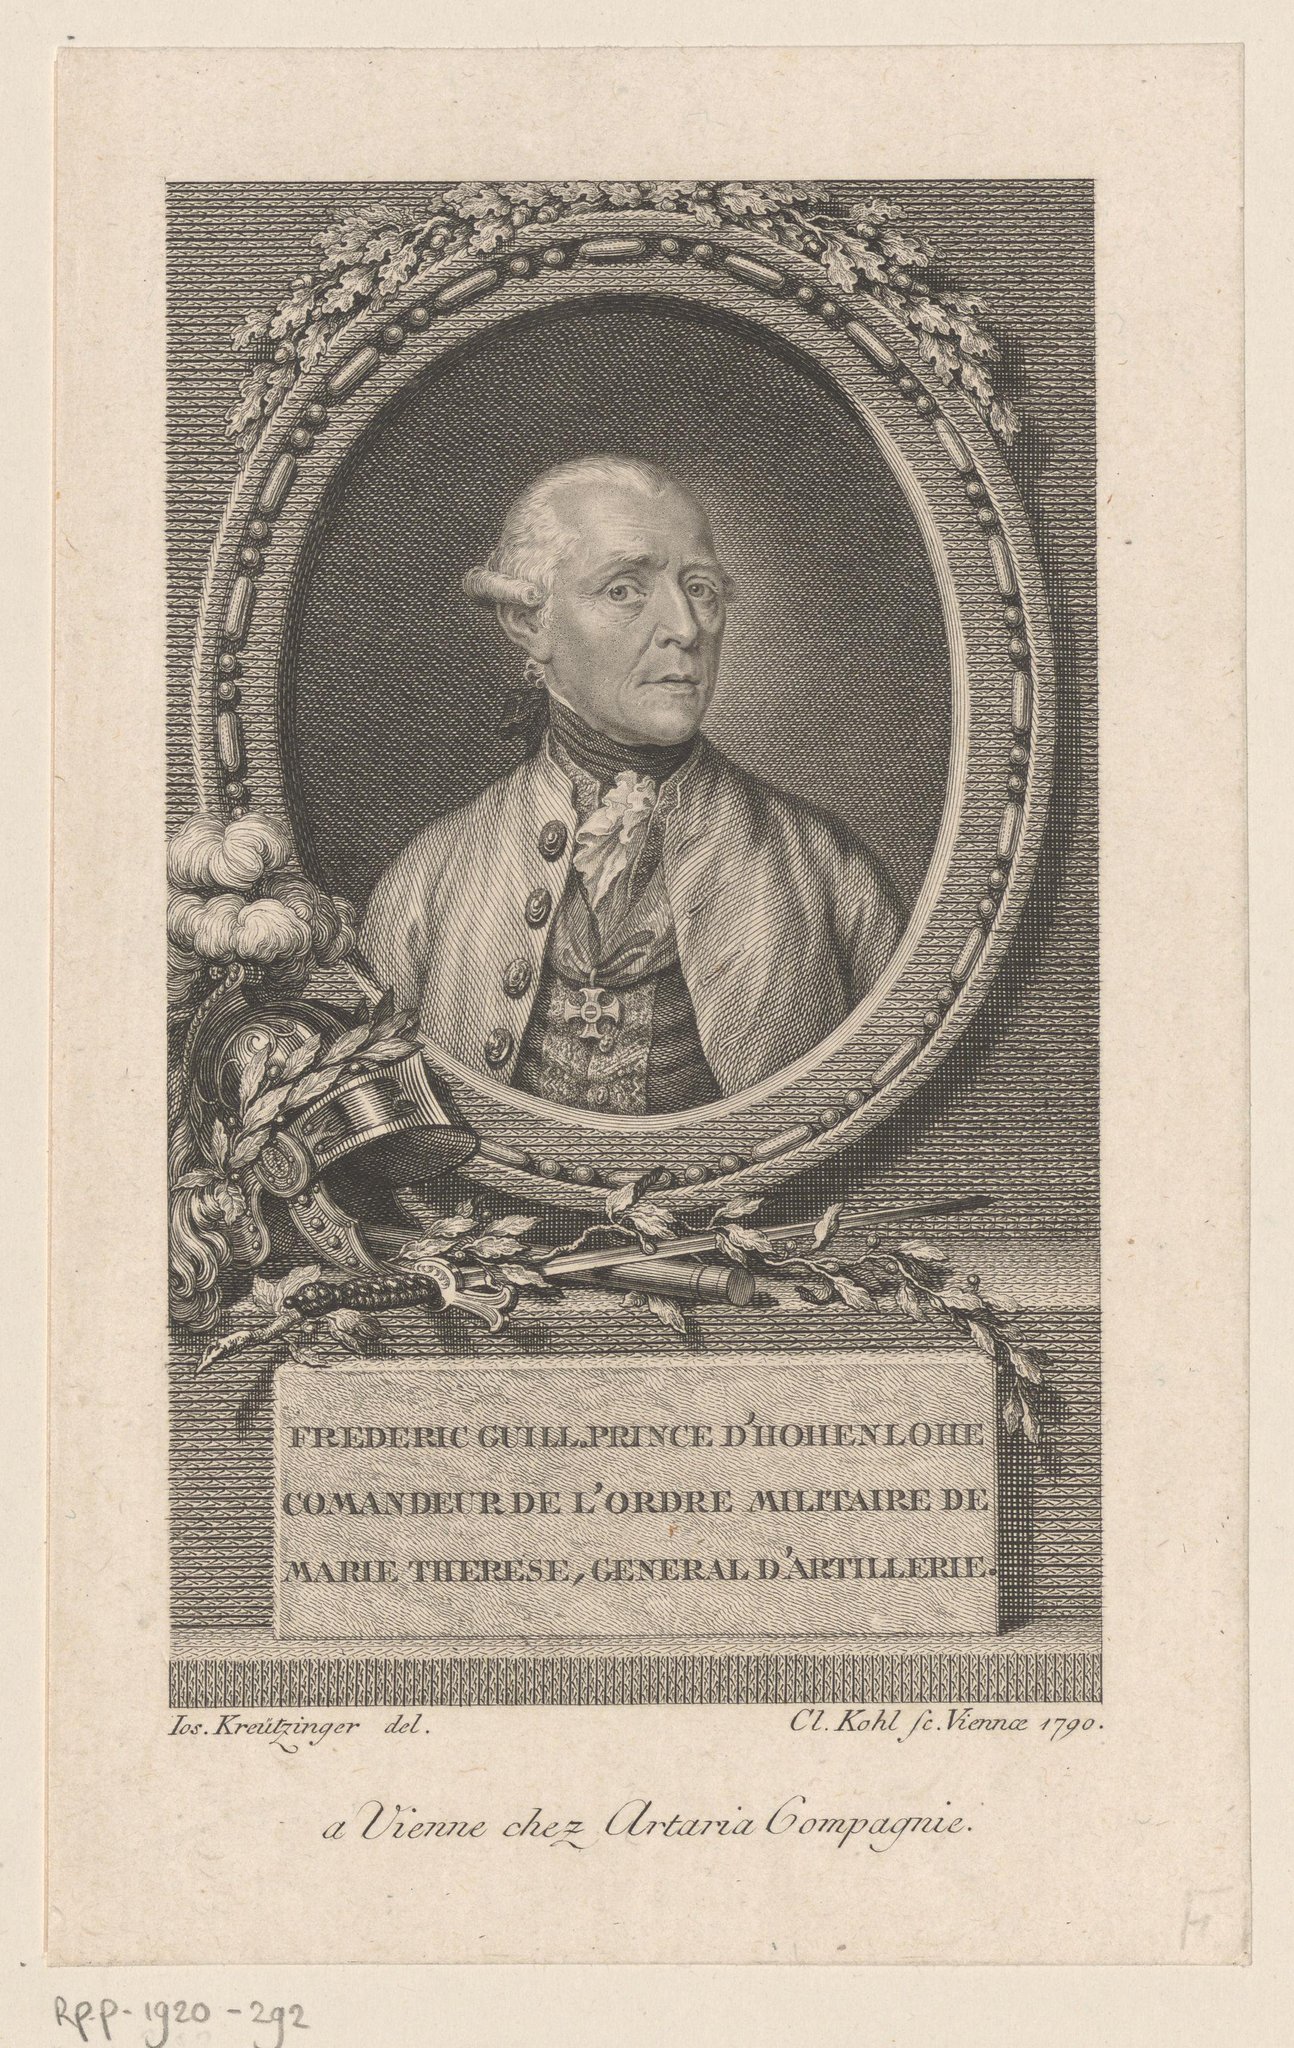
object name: print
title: Portret van Friedrich Wilhelm, prins van Hohenlohe-Kirchberg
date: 1790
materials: paper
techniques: engraving, etching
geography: vienna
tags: historical persons, officer, ornament ~ cartouche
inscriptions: collector's mark: Lugt 2228